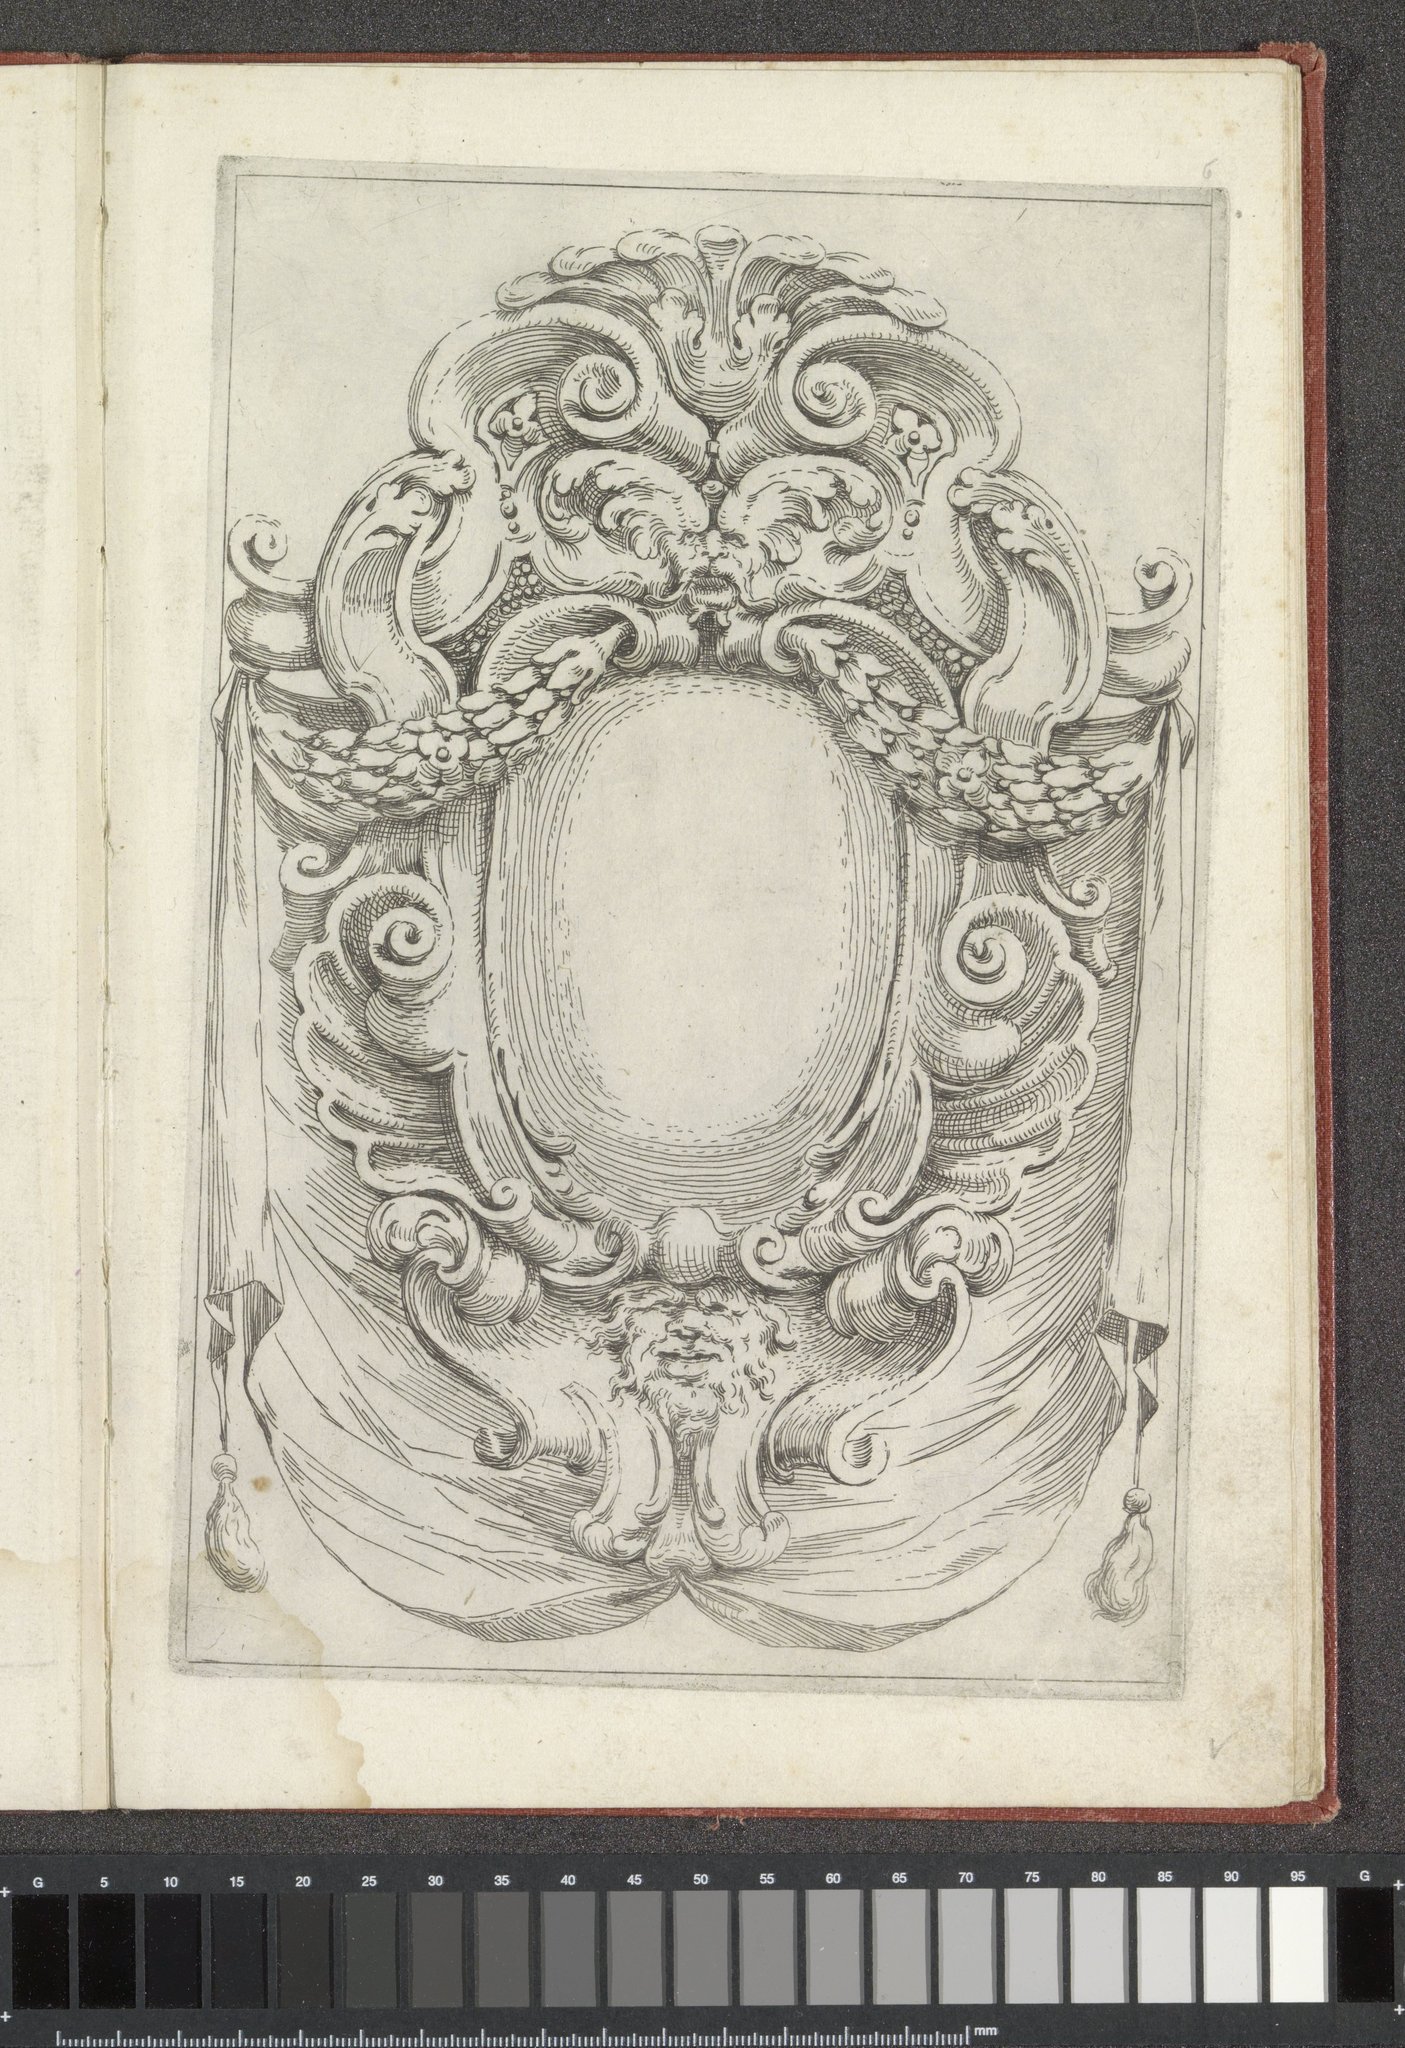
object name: album leaf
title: Cartouches par Mitelli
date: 1636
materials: paper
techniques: etching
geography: italy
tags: ornament ~ cartouche, ornament ~ festoon, garland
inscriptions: collector's mark: Lugt 2760, collector's mark: Lugt 2228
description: Een cartouche met in de rand festoenen en fantasiekoppen. De prent maakt deel uit van een album.